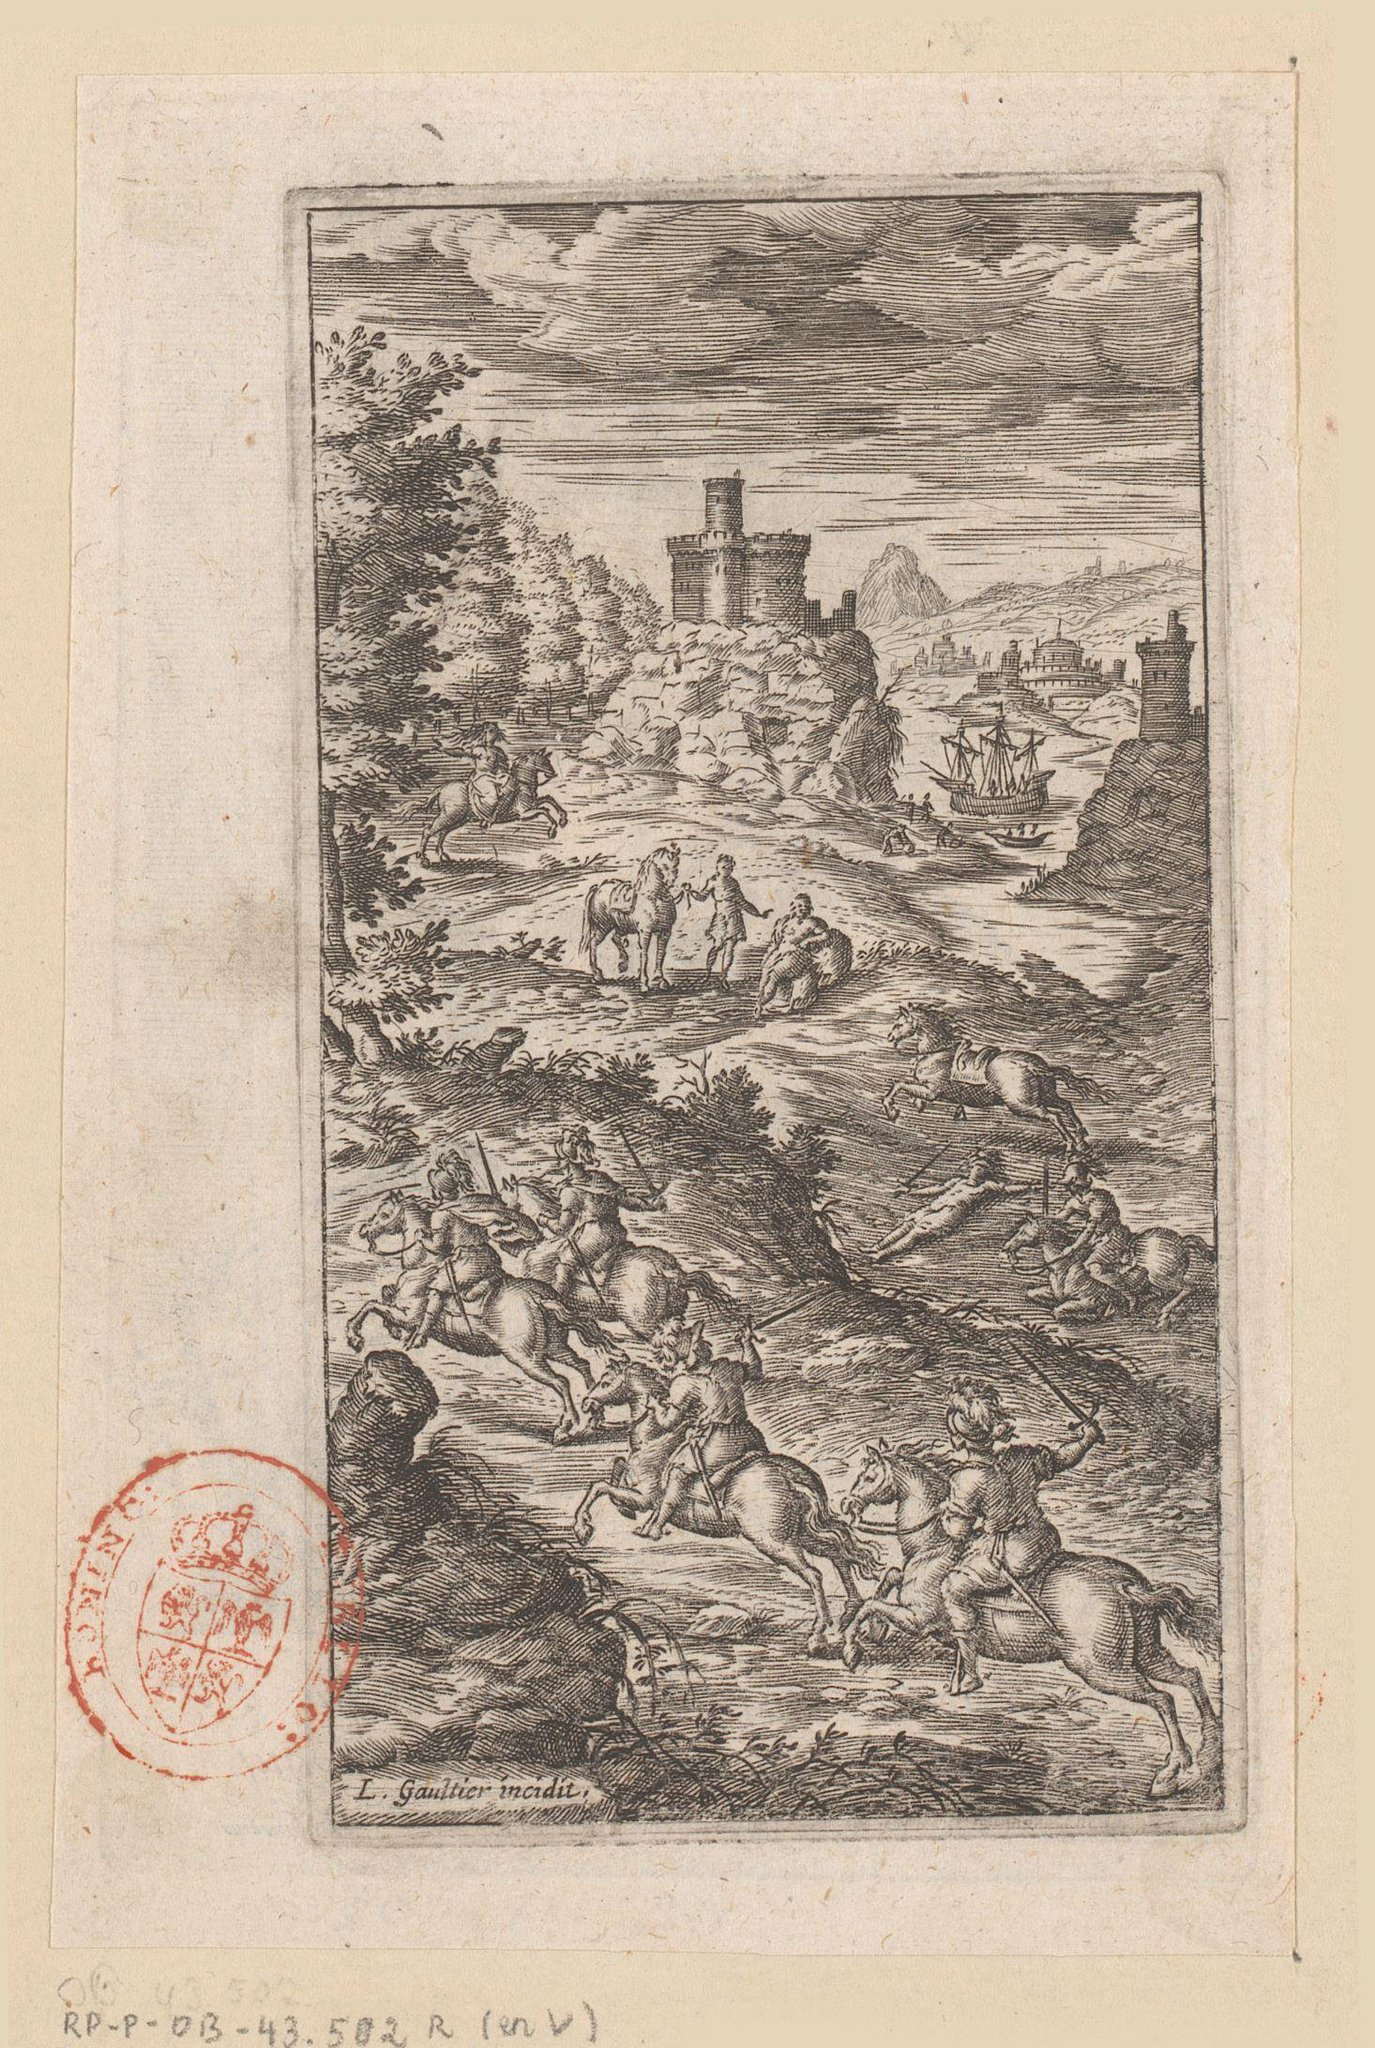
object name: print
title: Landschap met ruiters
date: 1622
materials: paper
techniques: engraving, etching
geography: france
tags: riding a horse, ass, or mule; rider, horseman, landscape with tower or castle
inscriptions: collector's mark: Lugt 240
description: Prent uit: Barclay, Jean. L'Argénis. Parijs: Claude Griset, 1624.